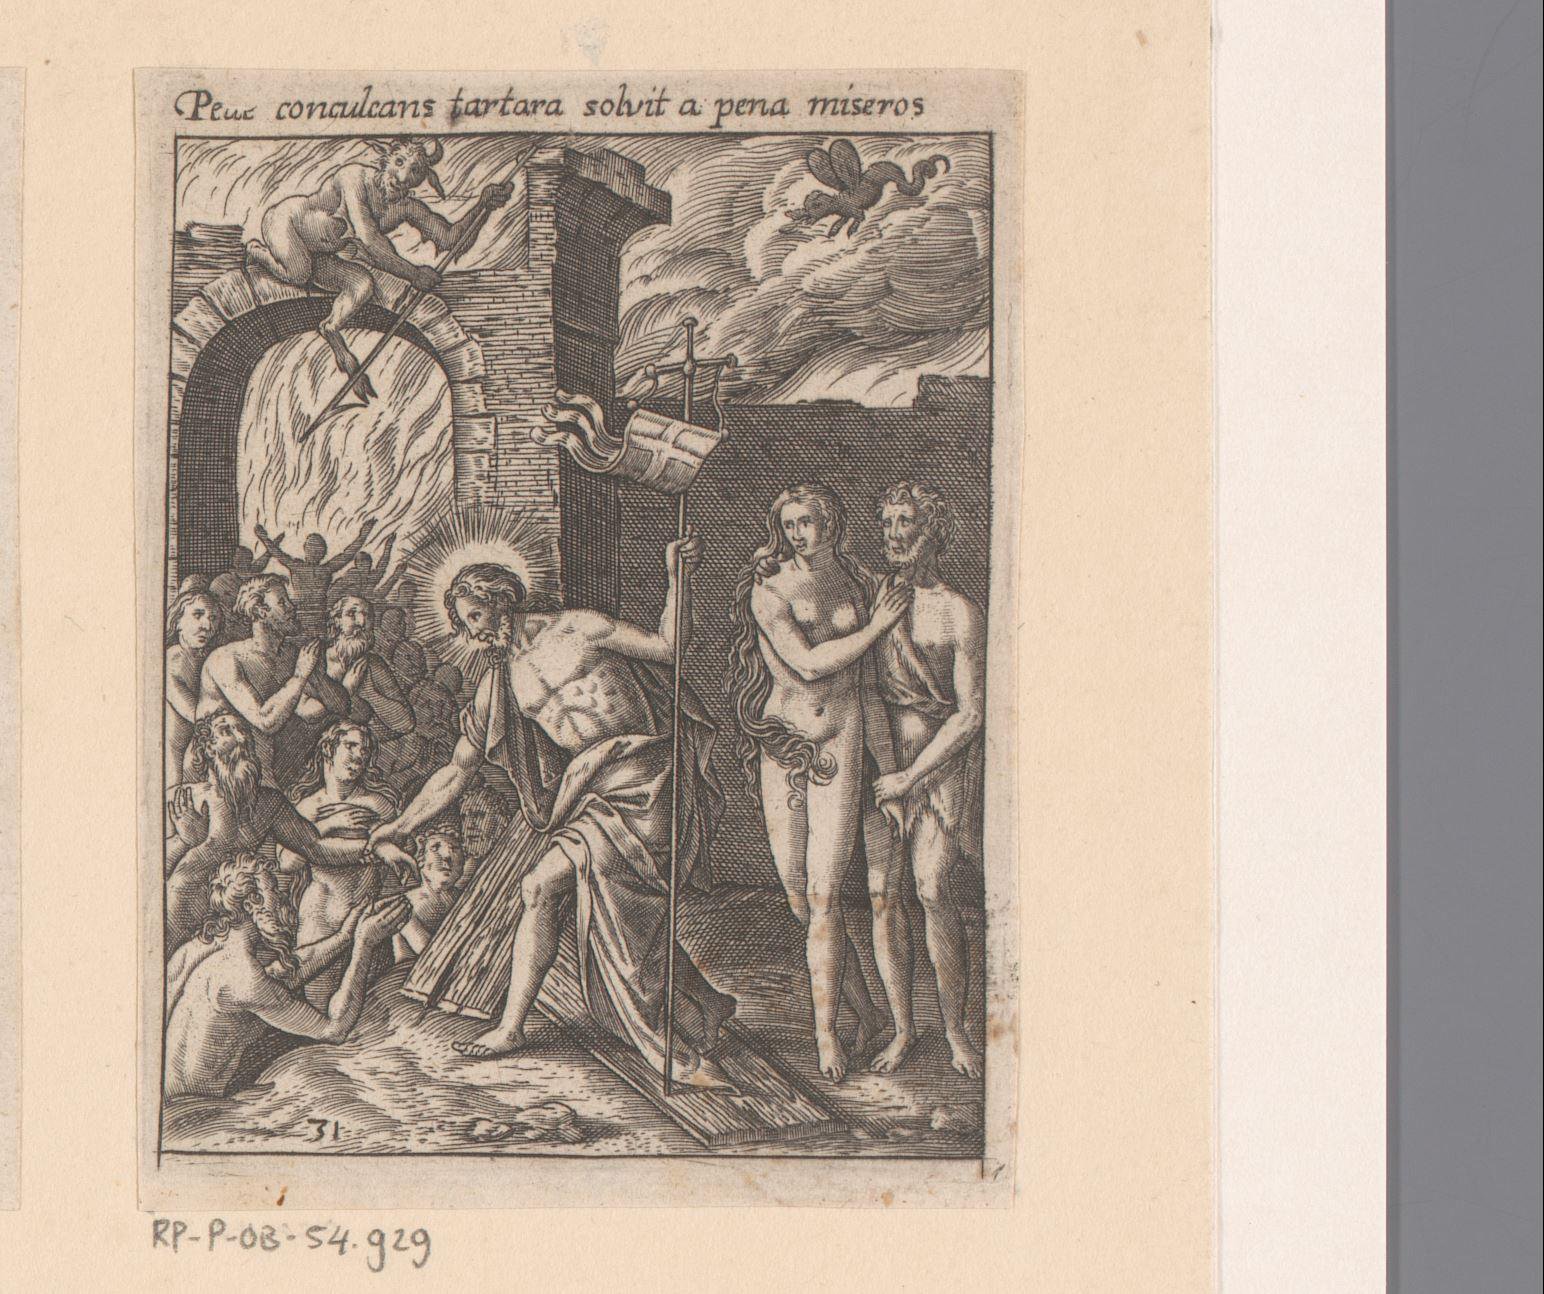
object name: print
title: Christus in het voorgeborchte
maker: heinrich ulrich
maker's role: draughtsman, painter, print maker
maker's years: 1572-1671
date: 1582-1671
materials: paper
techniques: engraving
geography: germany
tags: christ in the underworld, harrowing of hell, christ in limbo, 'descensus ad inferos', 'anastasis'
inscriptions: number: ‘38. - 64.’, collector's mark: Lugt 240